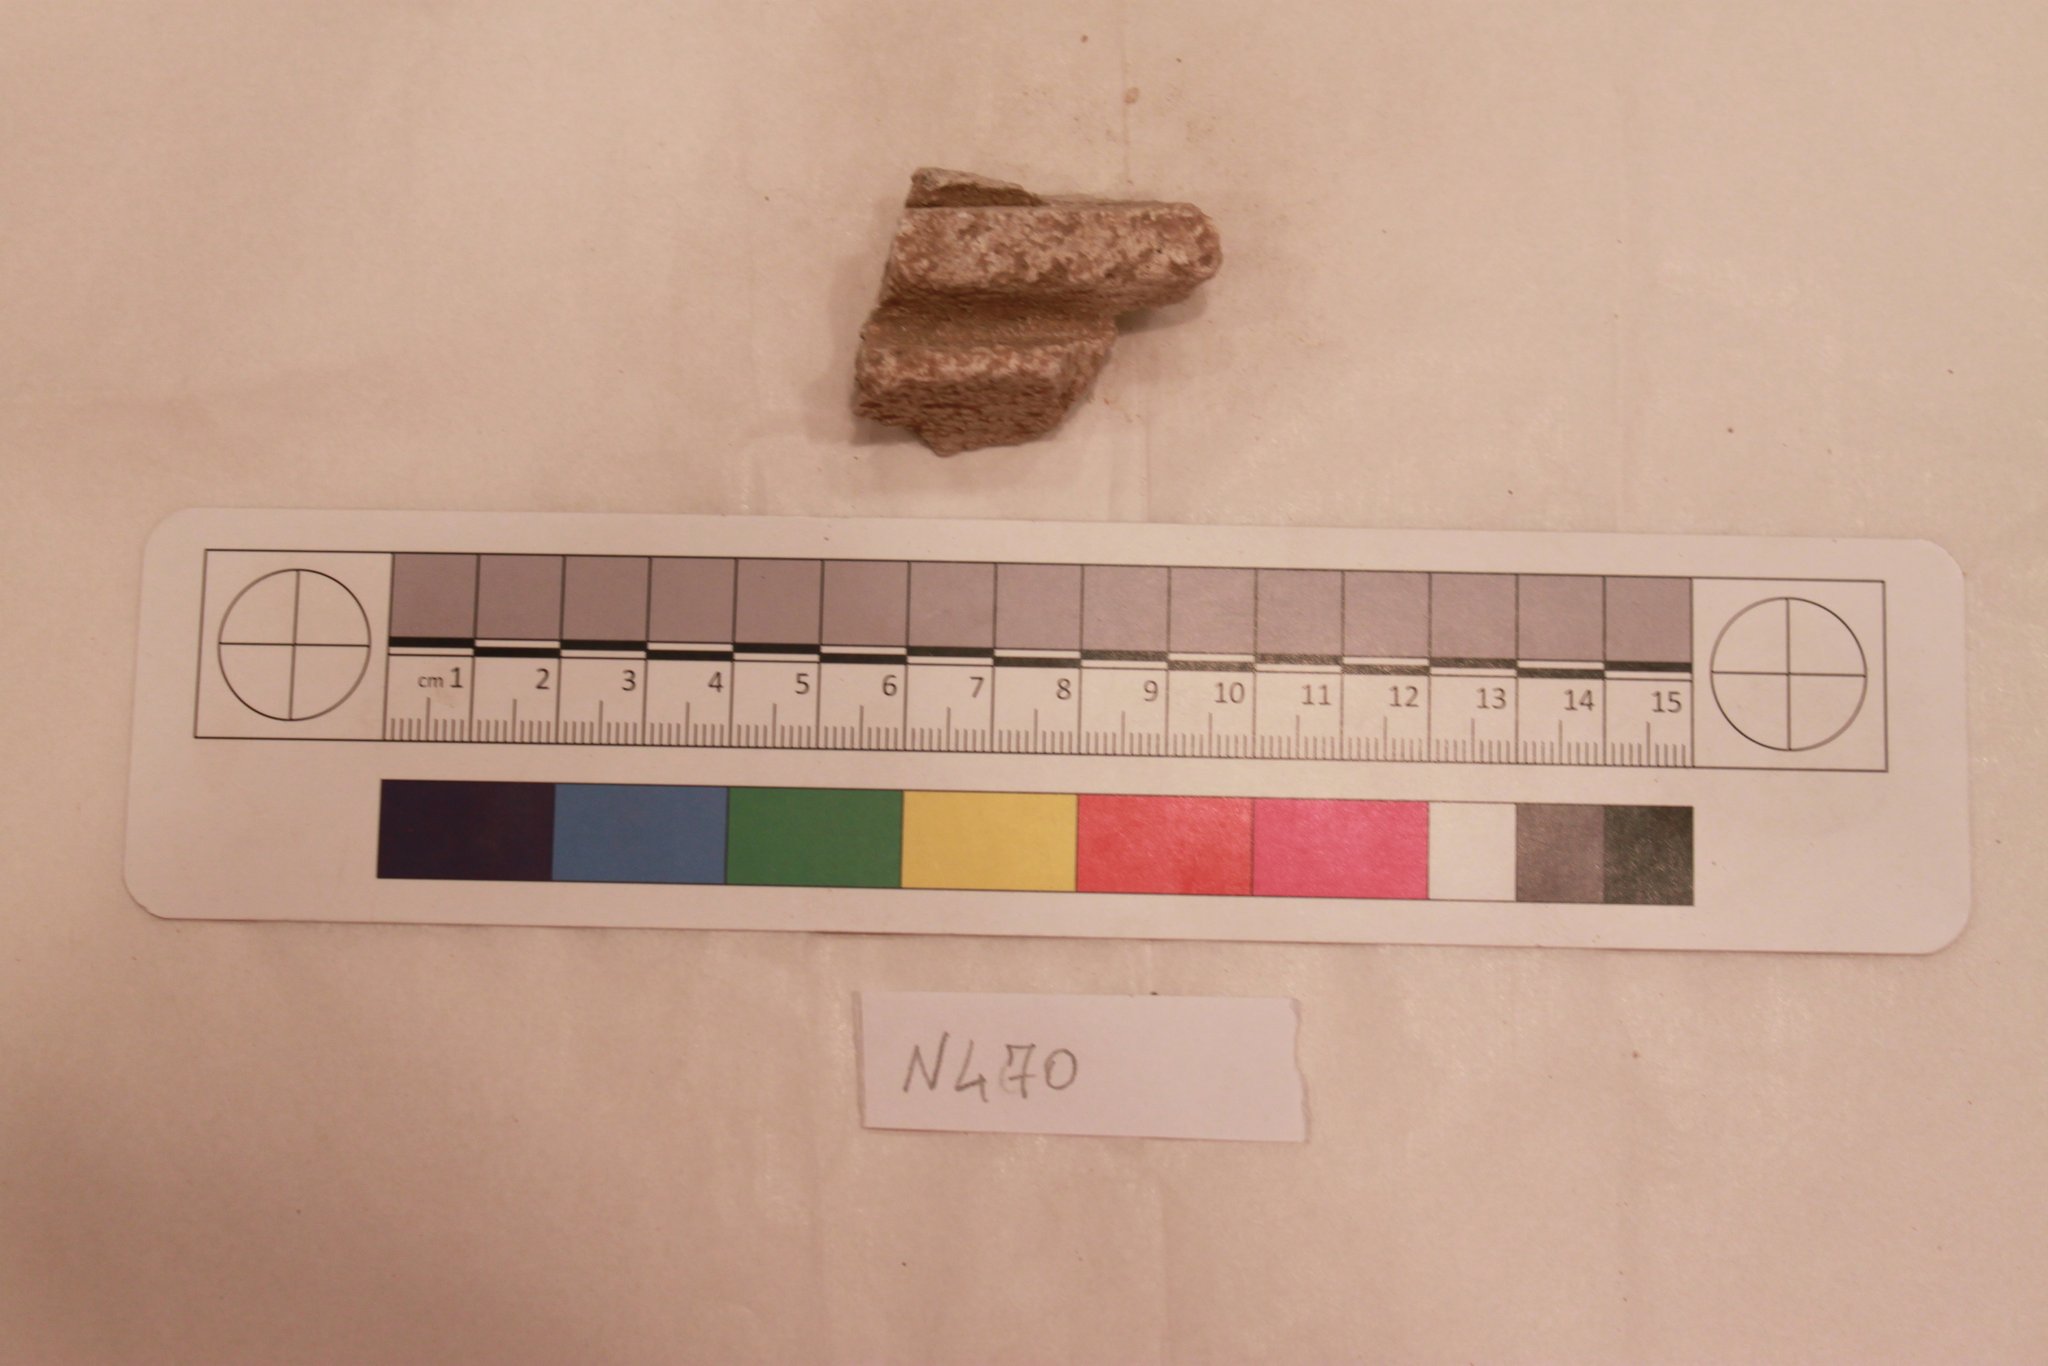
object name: fragment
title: Stucco Fragment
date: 701-1200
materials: plaster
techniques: carving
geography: iran